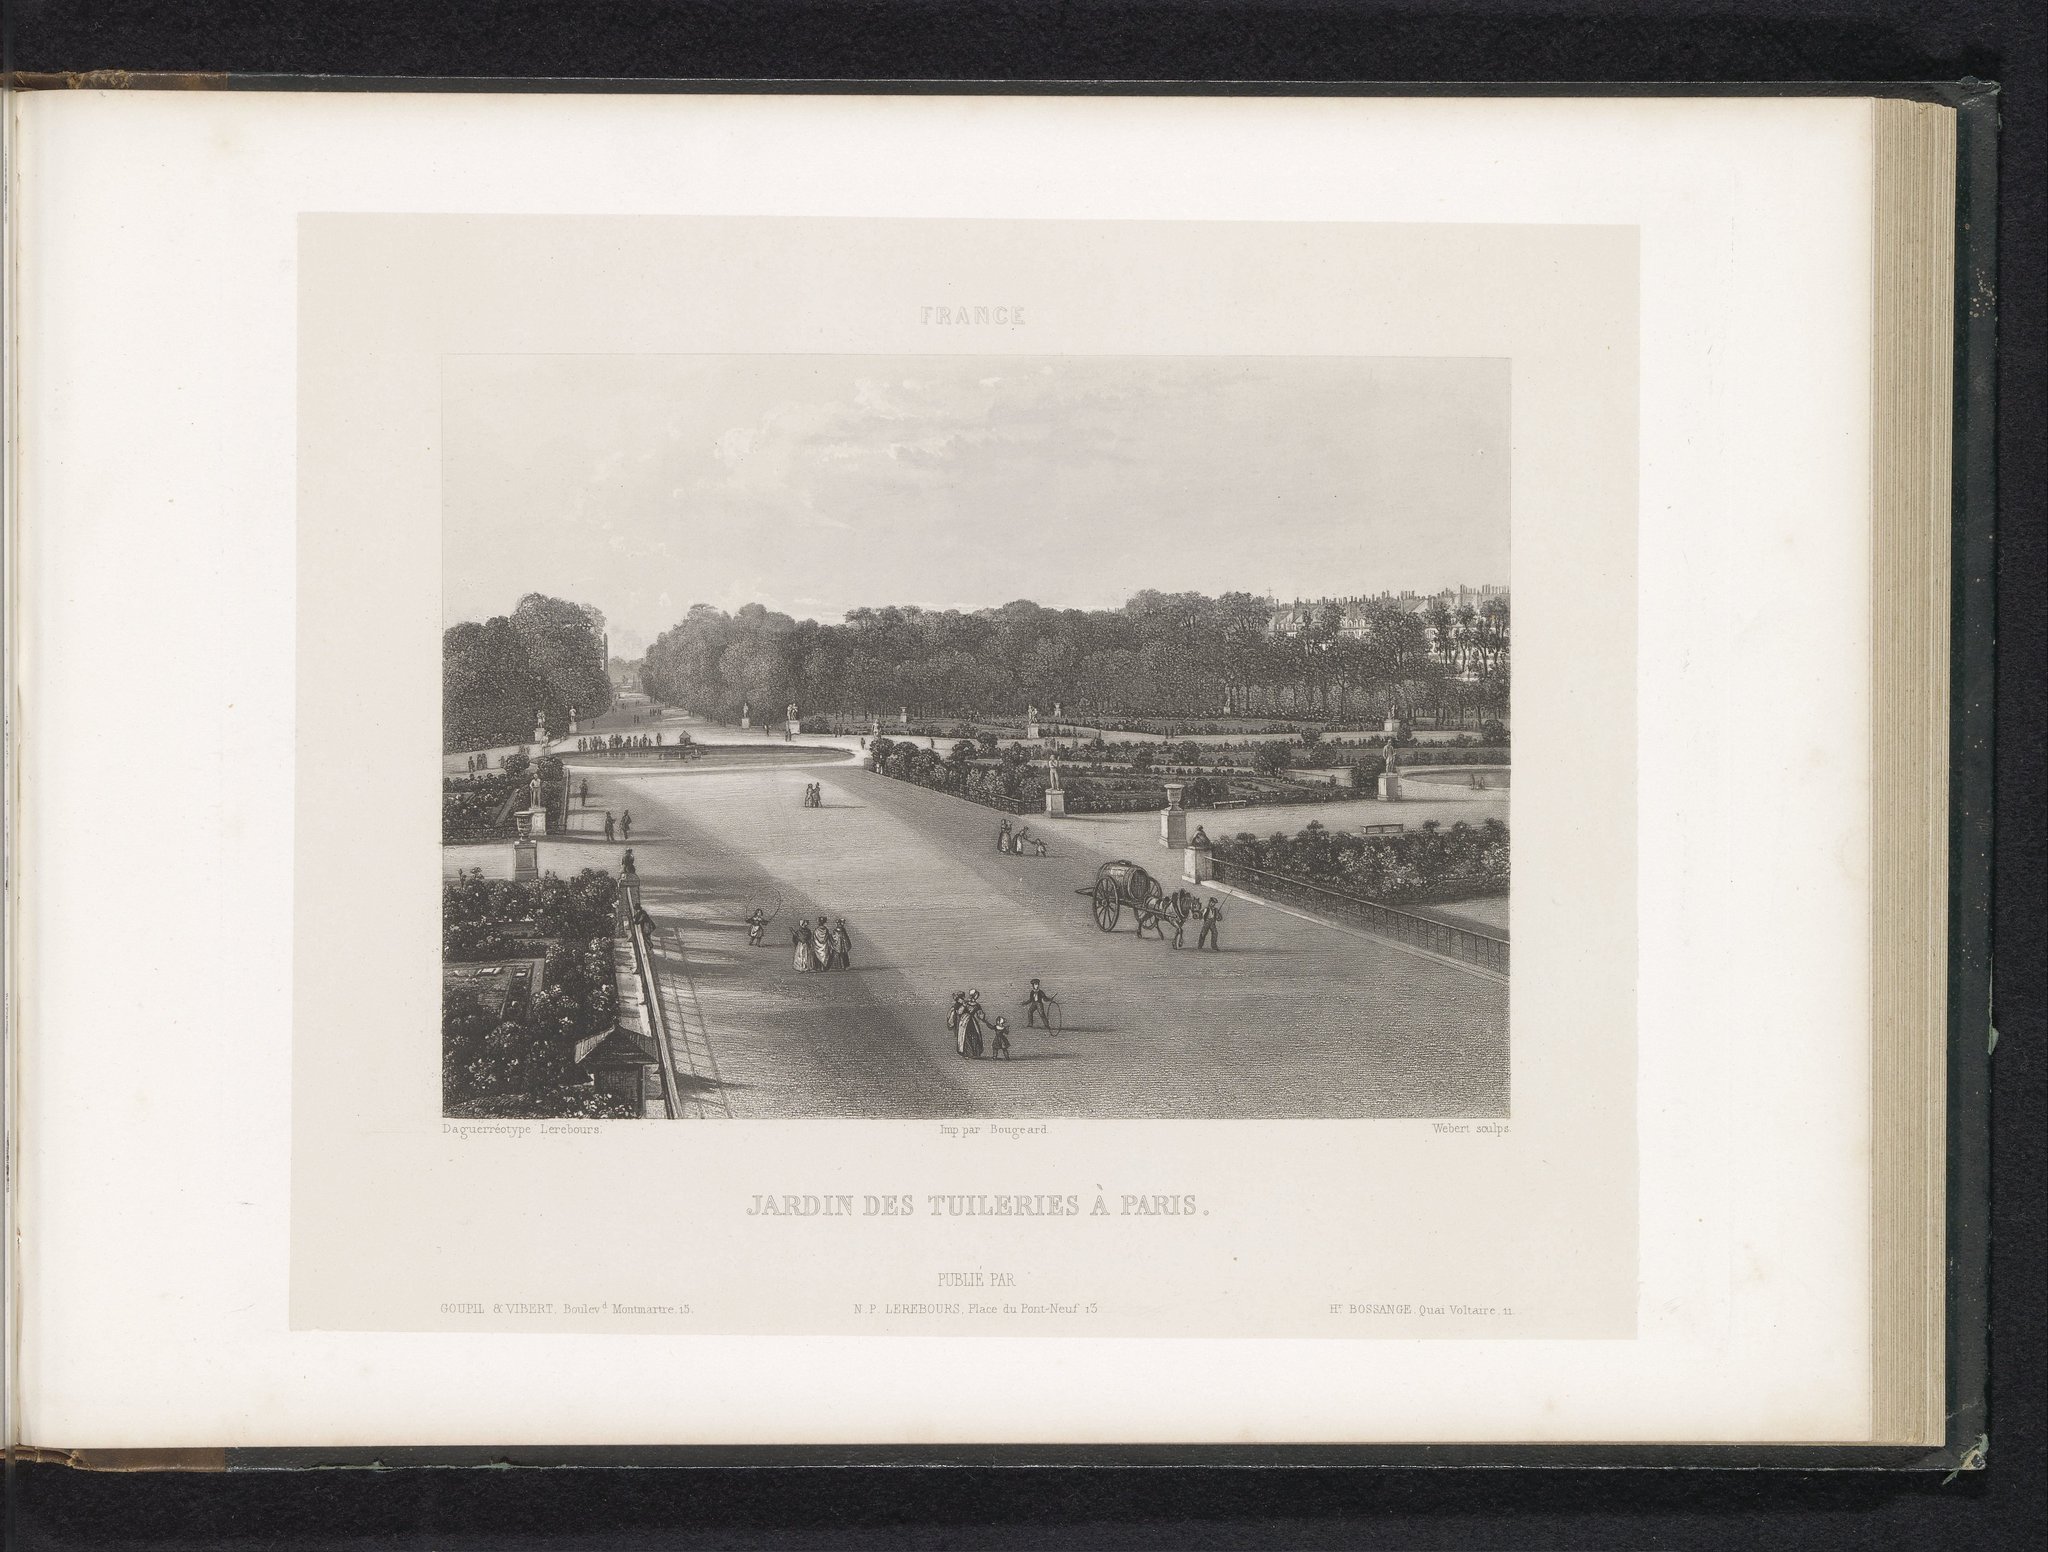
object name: print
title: Jardin des Tuileries à Paris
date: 1839-1841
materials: paper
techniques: aquatint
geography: paris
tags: french or architectonic garden; formal garden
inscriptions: inscription: ‘Rittner & Goupil Boulevd Montmartre 15’, inscription: ‘N.P. Lerebours Place du Pont Neuf 15’, inscription: ‘Hr. Bossance Quai Voltaire 11’